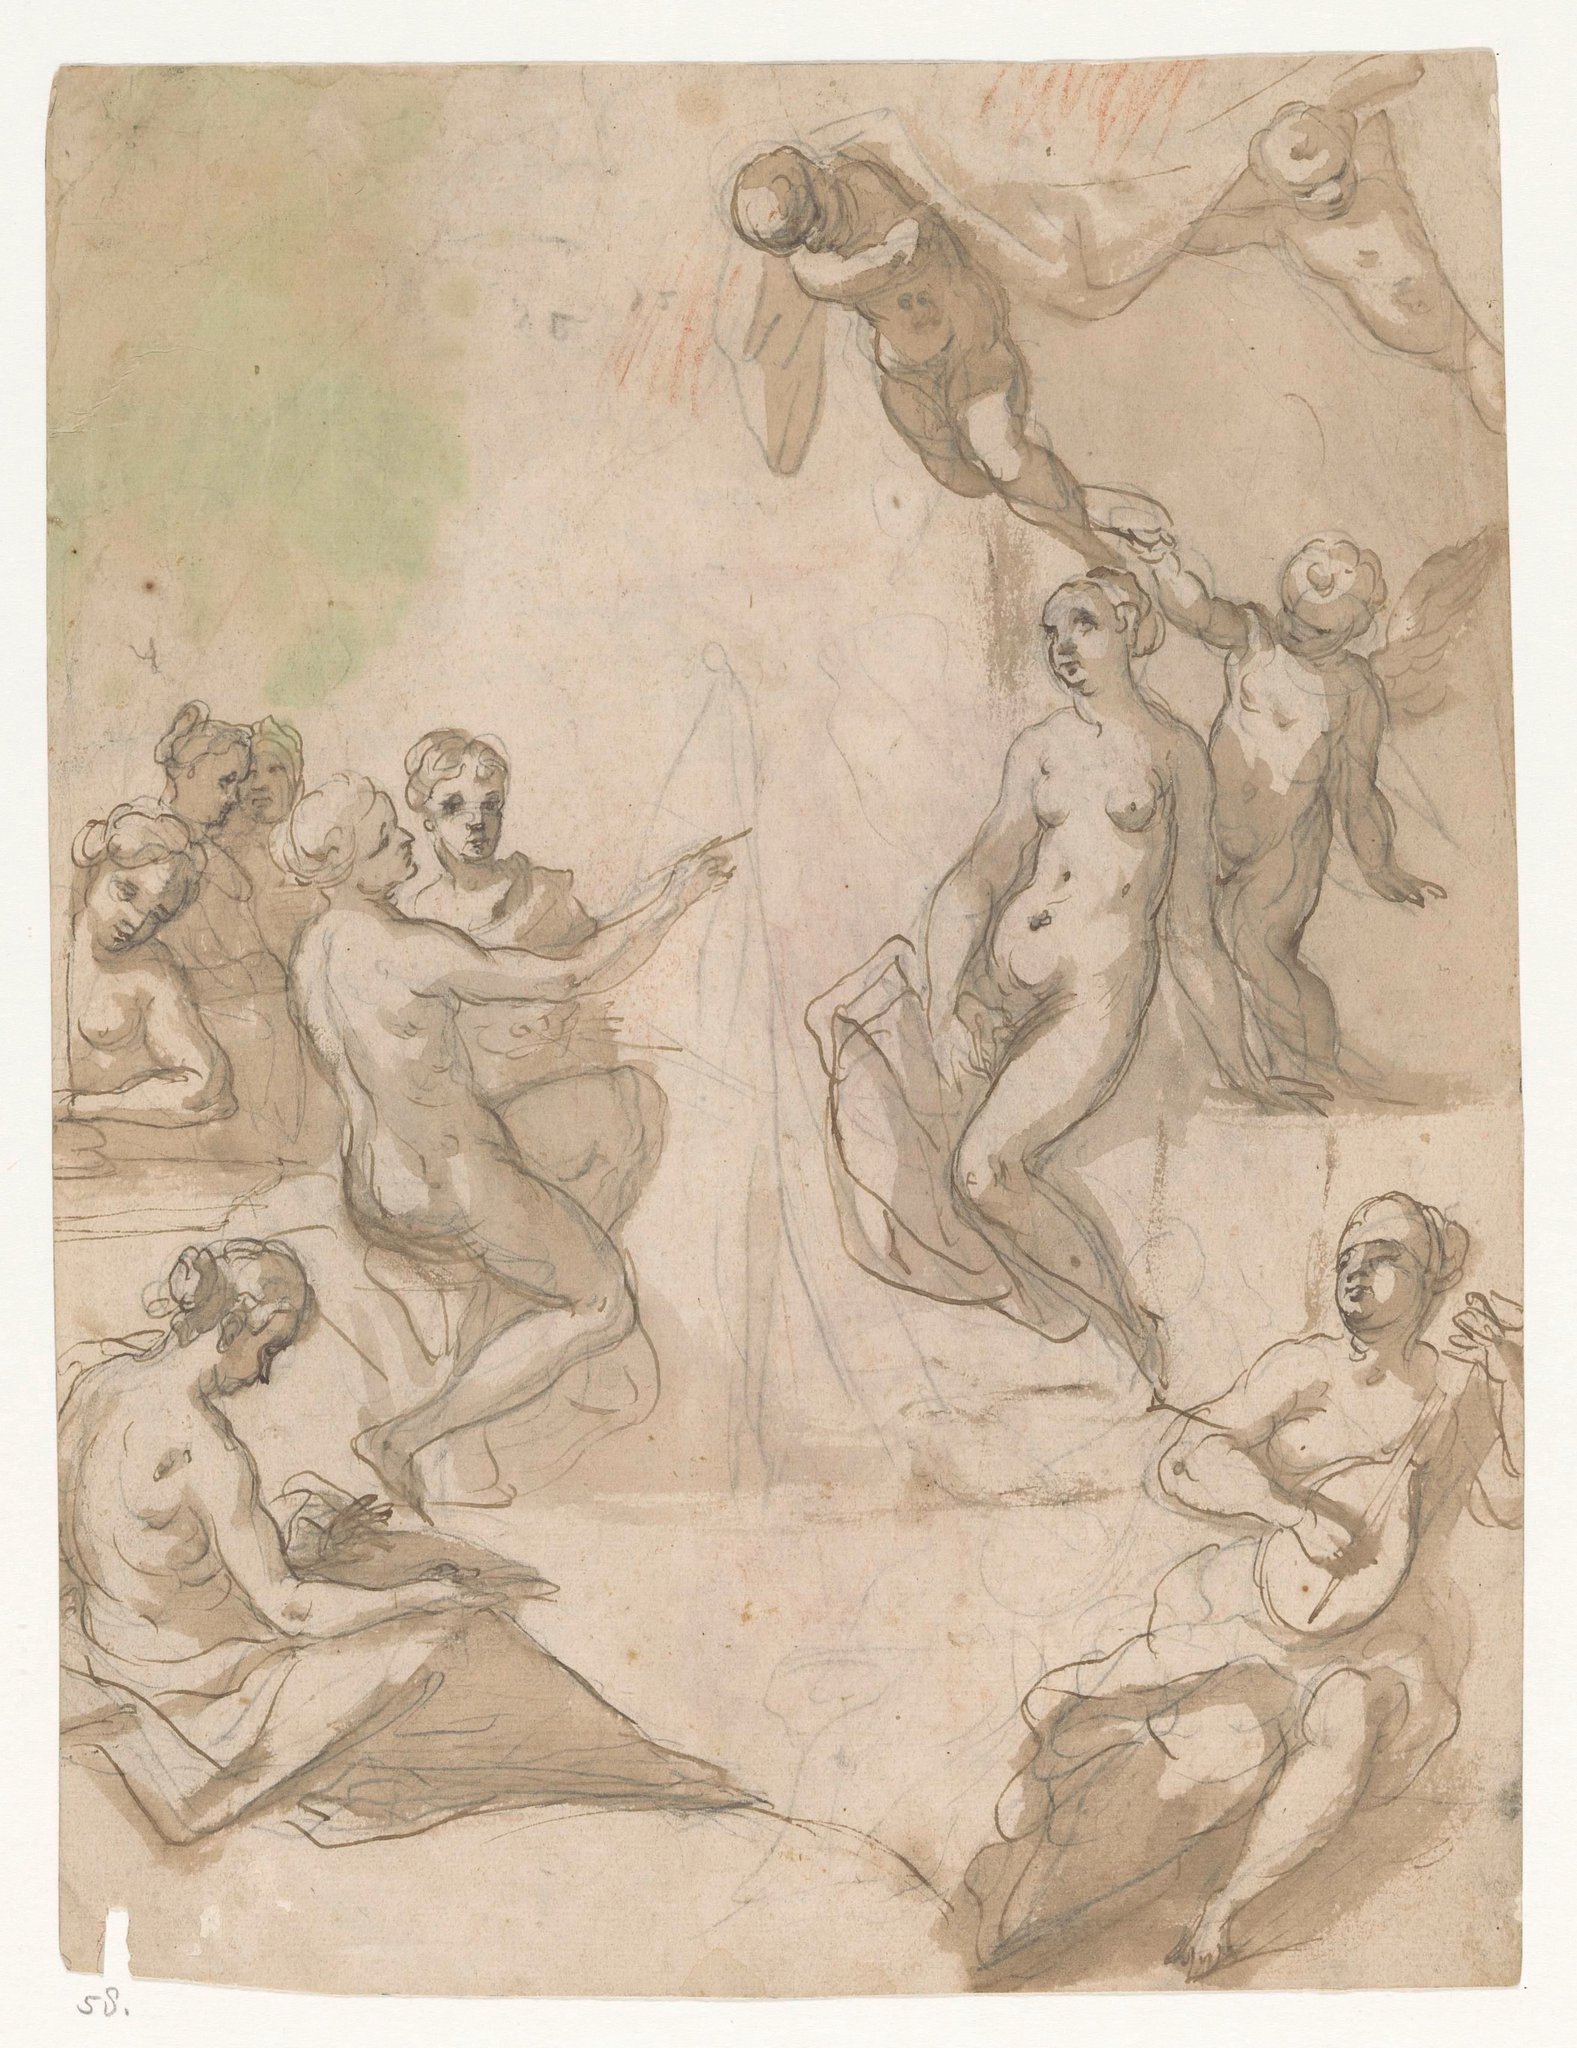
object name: drawing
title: Venus laat haar portret schilderen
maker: Anonymous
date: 1600-1625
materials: ink, paper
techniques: brush, pen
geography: germany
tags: bodegraven, draughtsman, jan brandes, painting ~ applied arts (+ model, sitter), non-aggressive, friendly or neutral activities and relationships of venus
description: Engelen of nimfen rond Venus die haar portret laat schilderen.